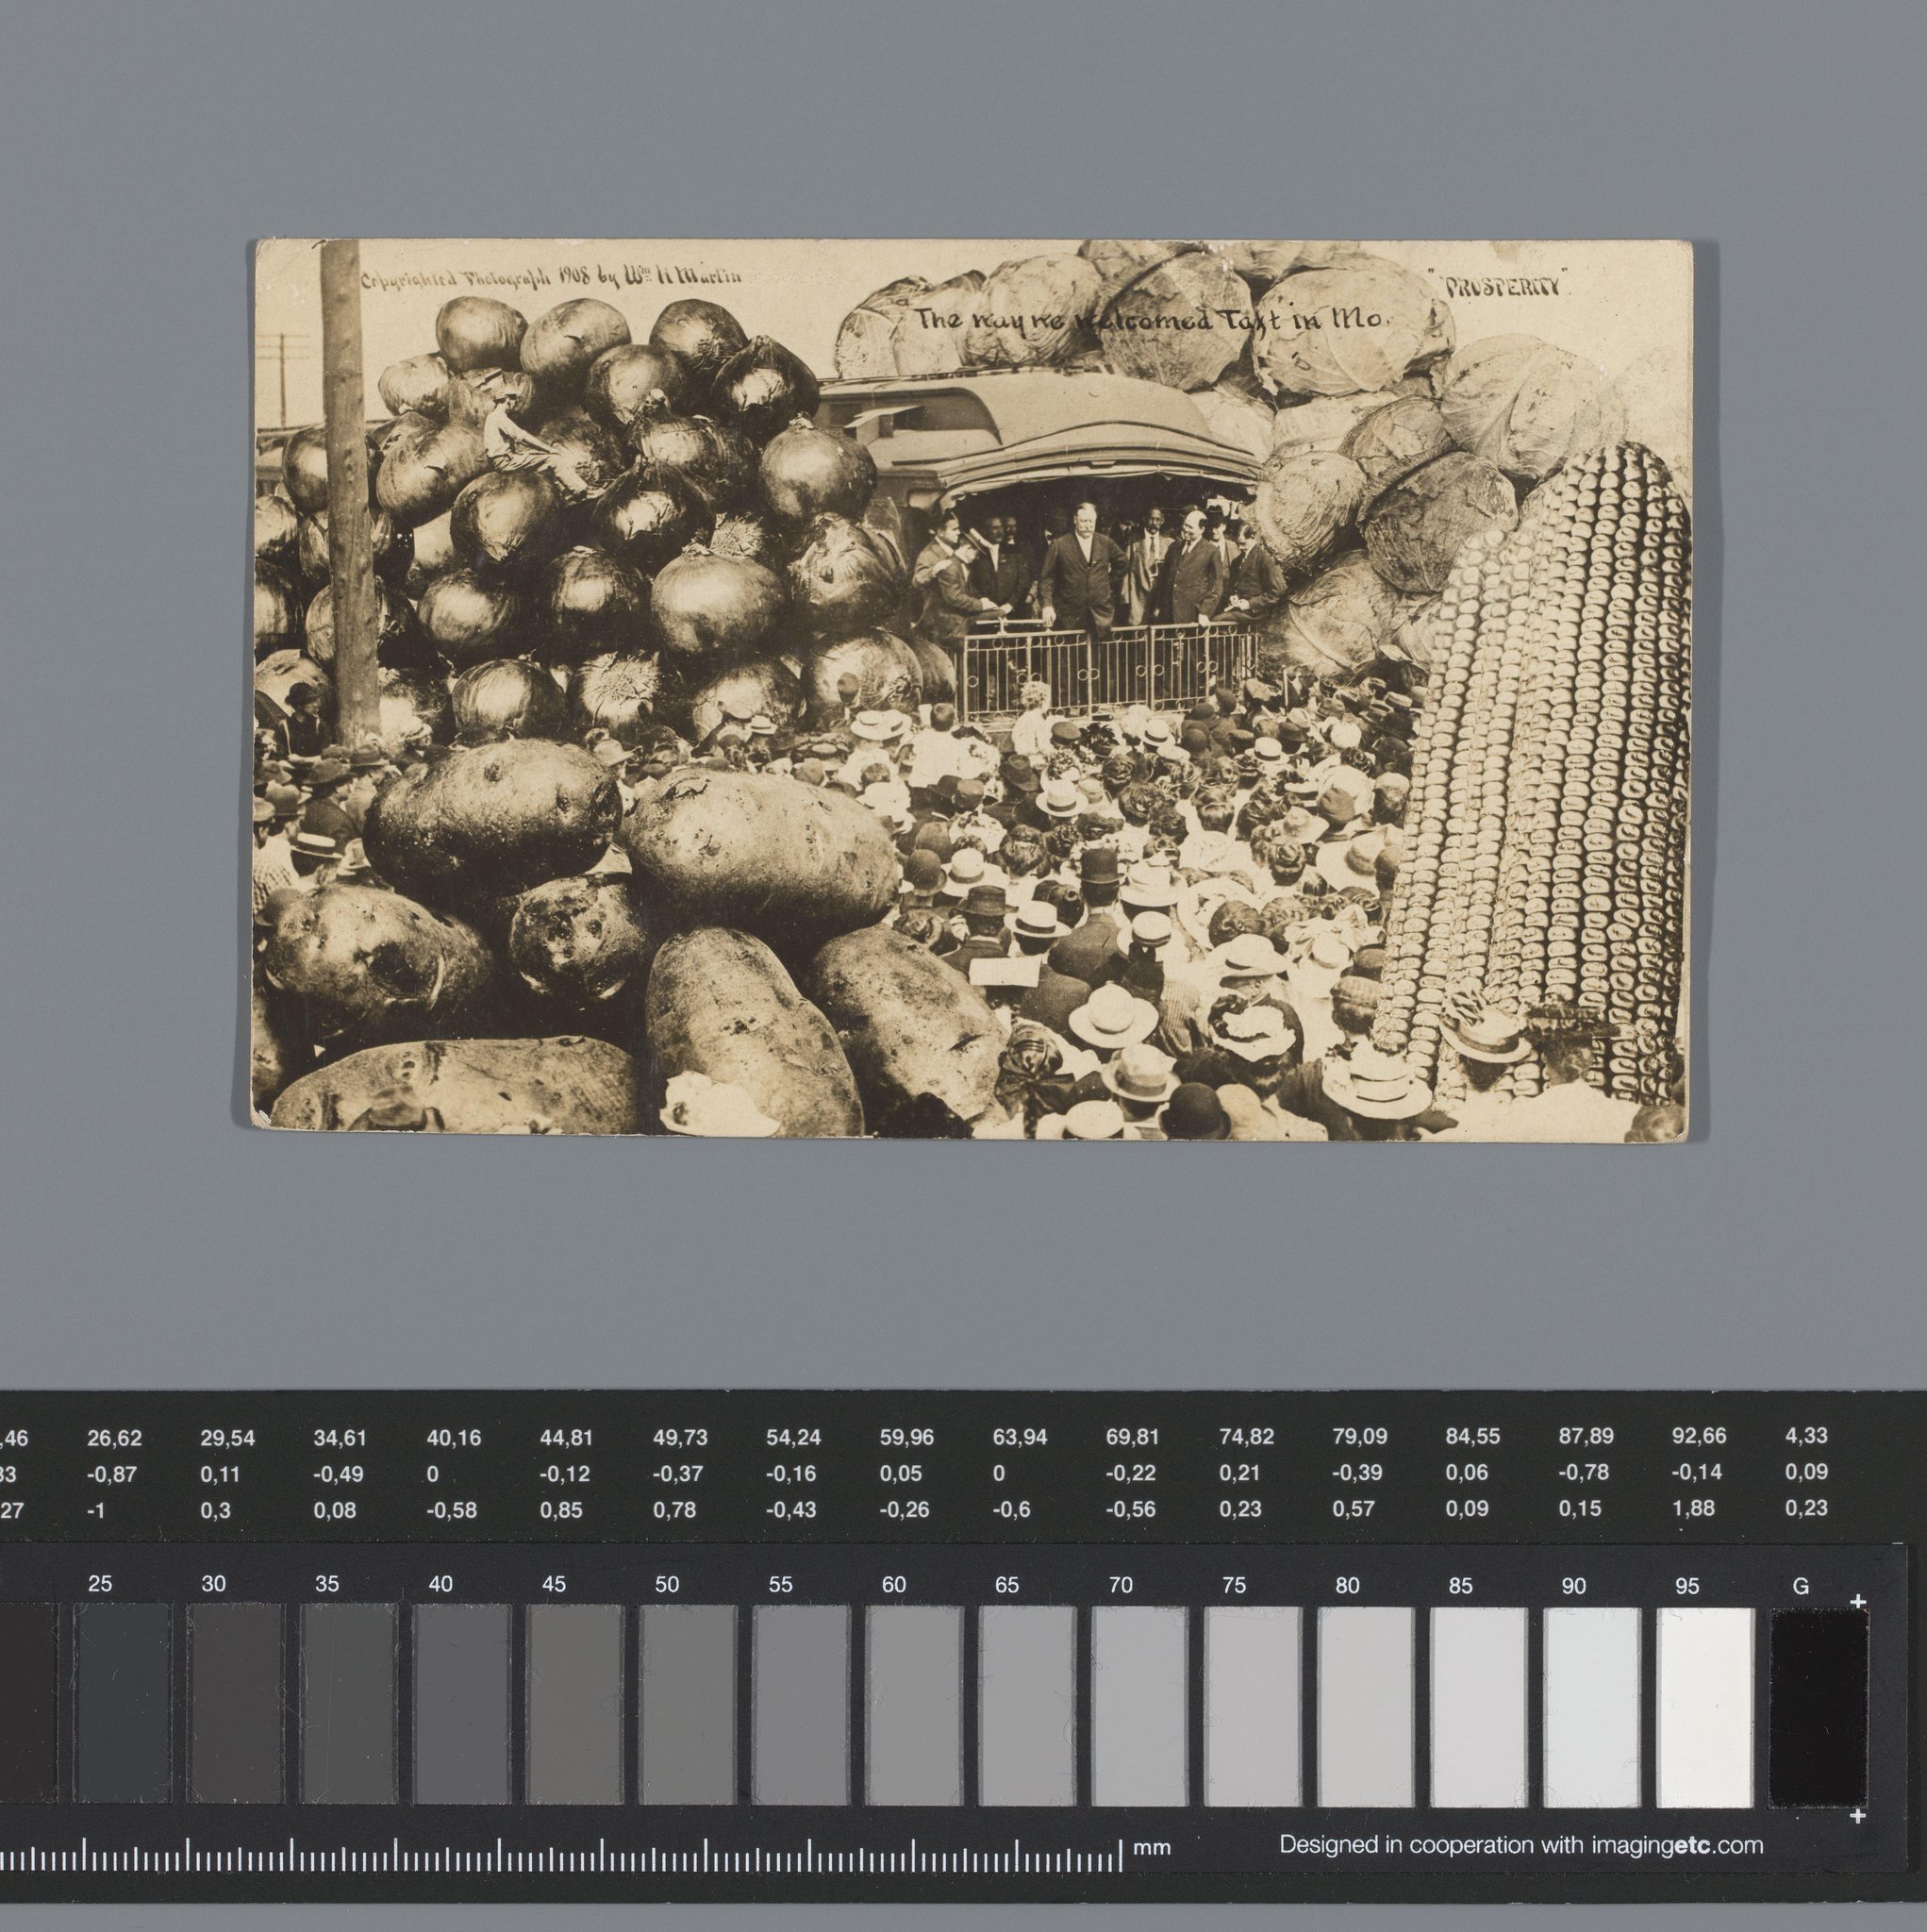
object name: ansichtkaart, prentbriefkaart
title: Fotomontage van President William Howard Taft die in Missouri een menigte toespreekt tussen reusachtige gewassen (uien, mais, kolen en aardappels)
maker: william h. martin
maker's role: fotograaf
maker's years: 1865-1940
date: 1908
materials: photographic support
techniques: gelatin silver print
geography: united states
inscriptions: inscription: ‘PUBLISHED BY / THE NORTH AMERICAN POST CARD CO. / KANSAS CITY, U. S. A.’, inscription: ‘Copyright Photograph 1908 by Wm H Martin / The way we welcomed Taft in Mo., / “PROSPERITY”’, inscription: ‘PERRYSBURG / AUG / 8 / 19[…] / 2 PM /’